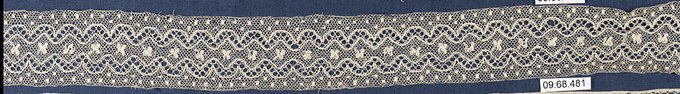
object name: insertion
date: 1801-1900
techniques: lace